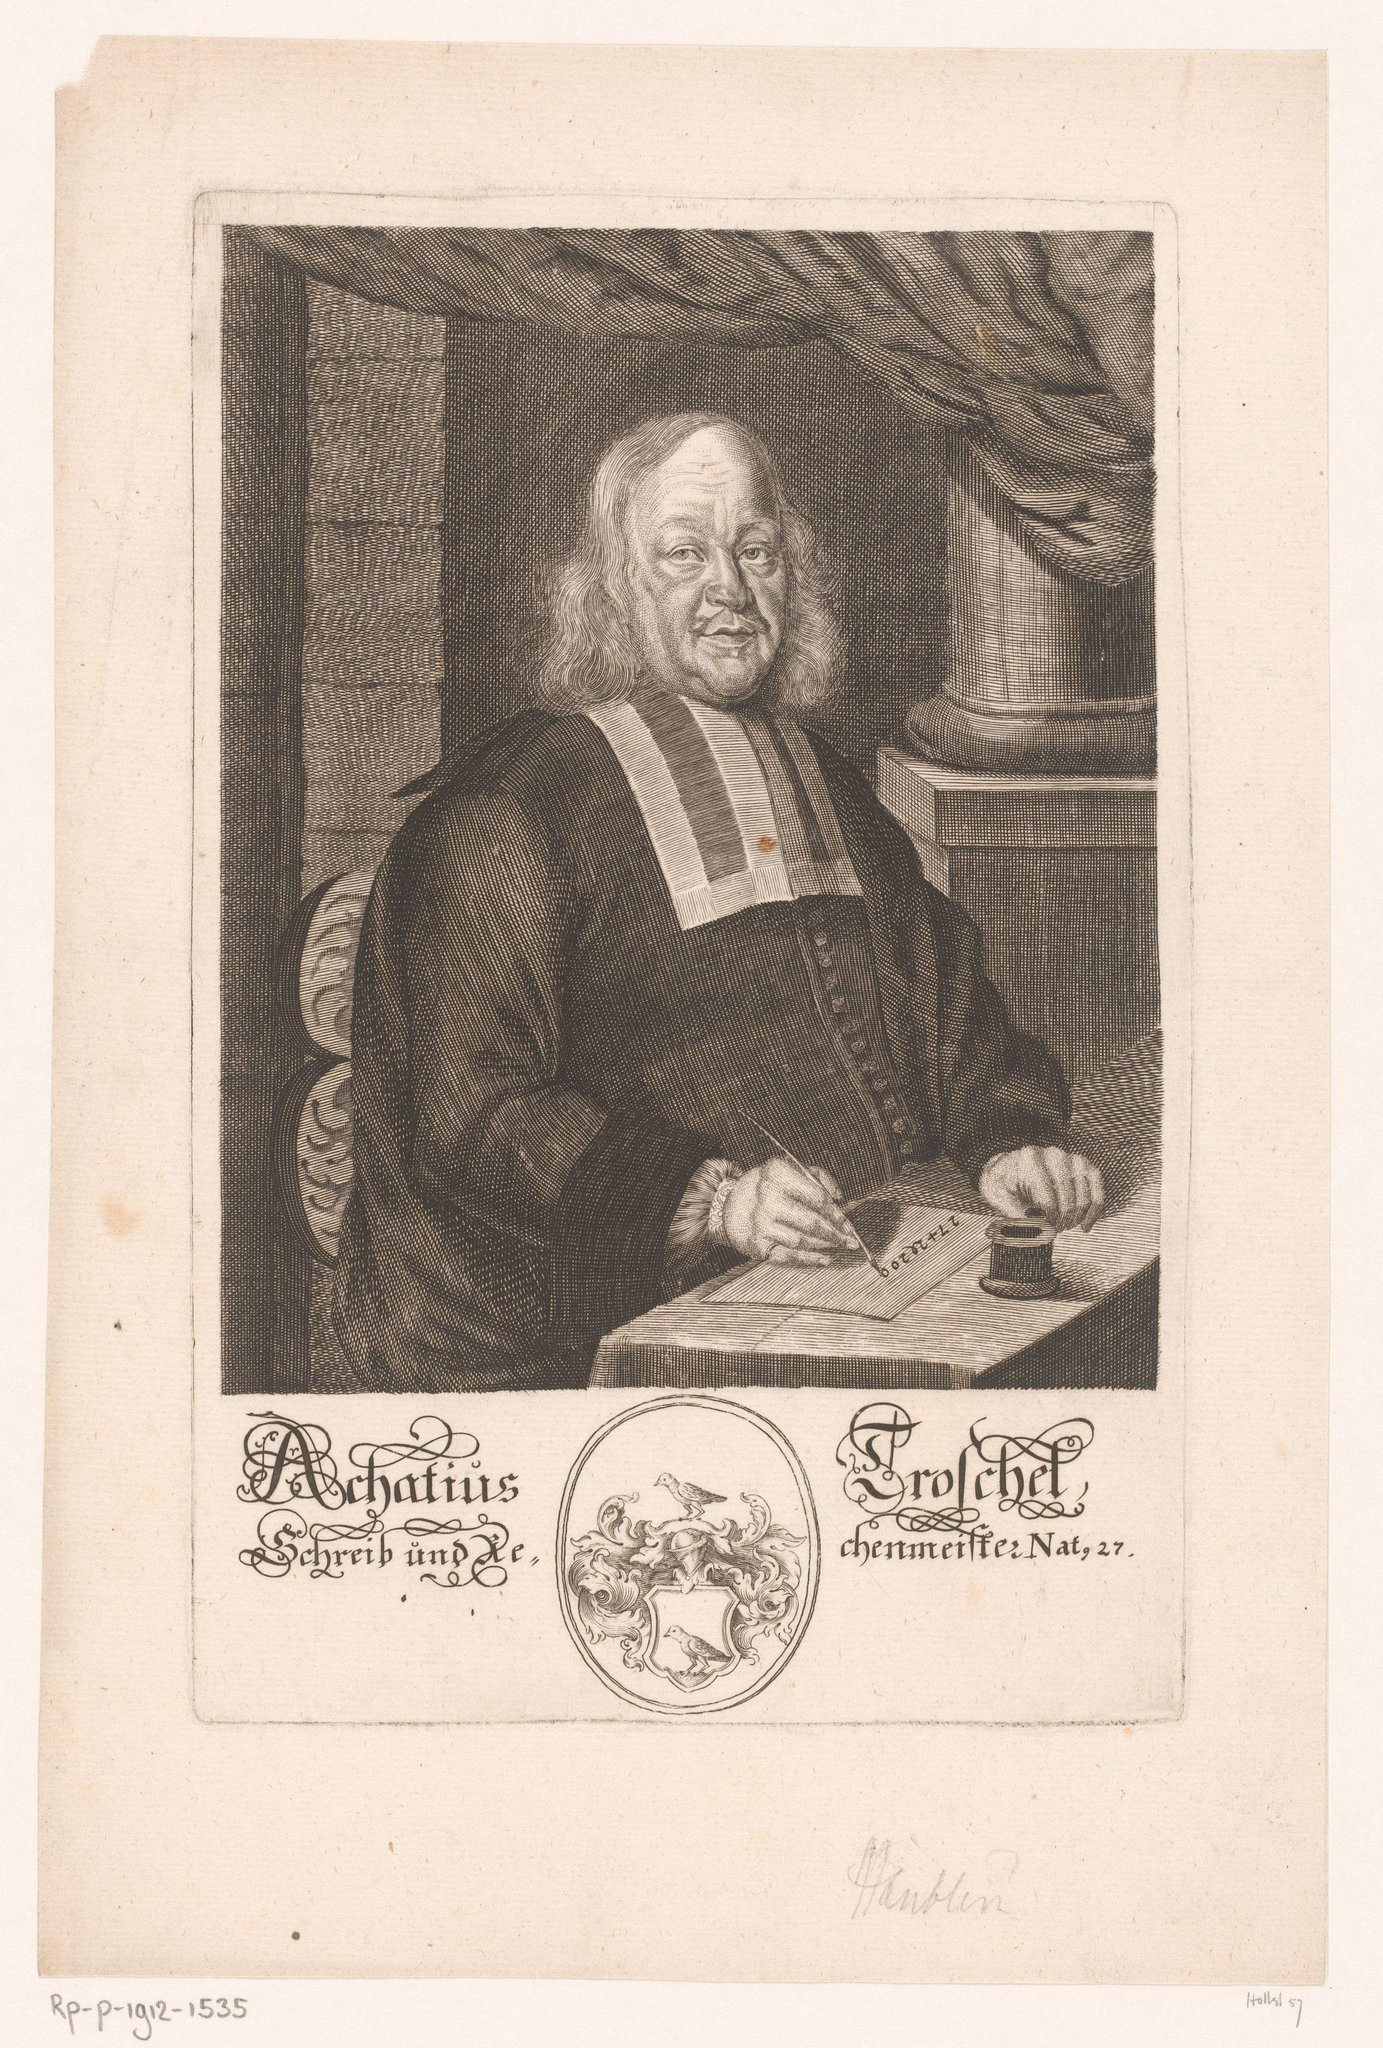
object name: print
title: Portret van Achatius Troschel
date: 1650-1689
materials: paper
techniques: engraving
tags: historical persons, armorial bearing, heraldry, mathematics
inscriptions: collector's mark: Lugt 2228